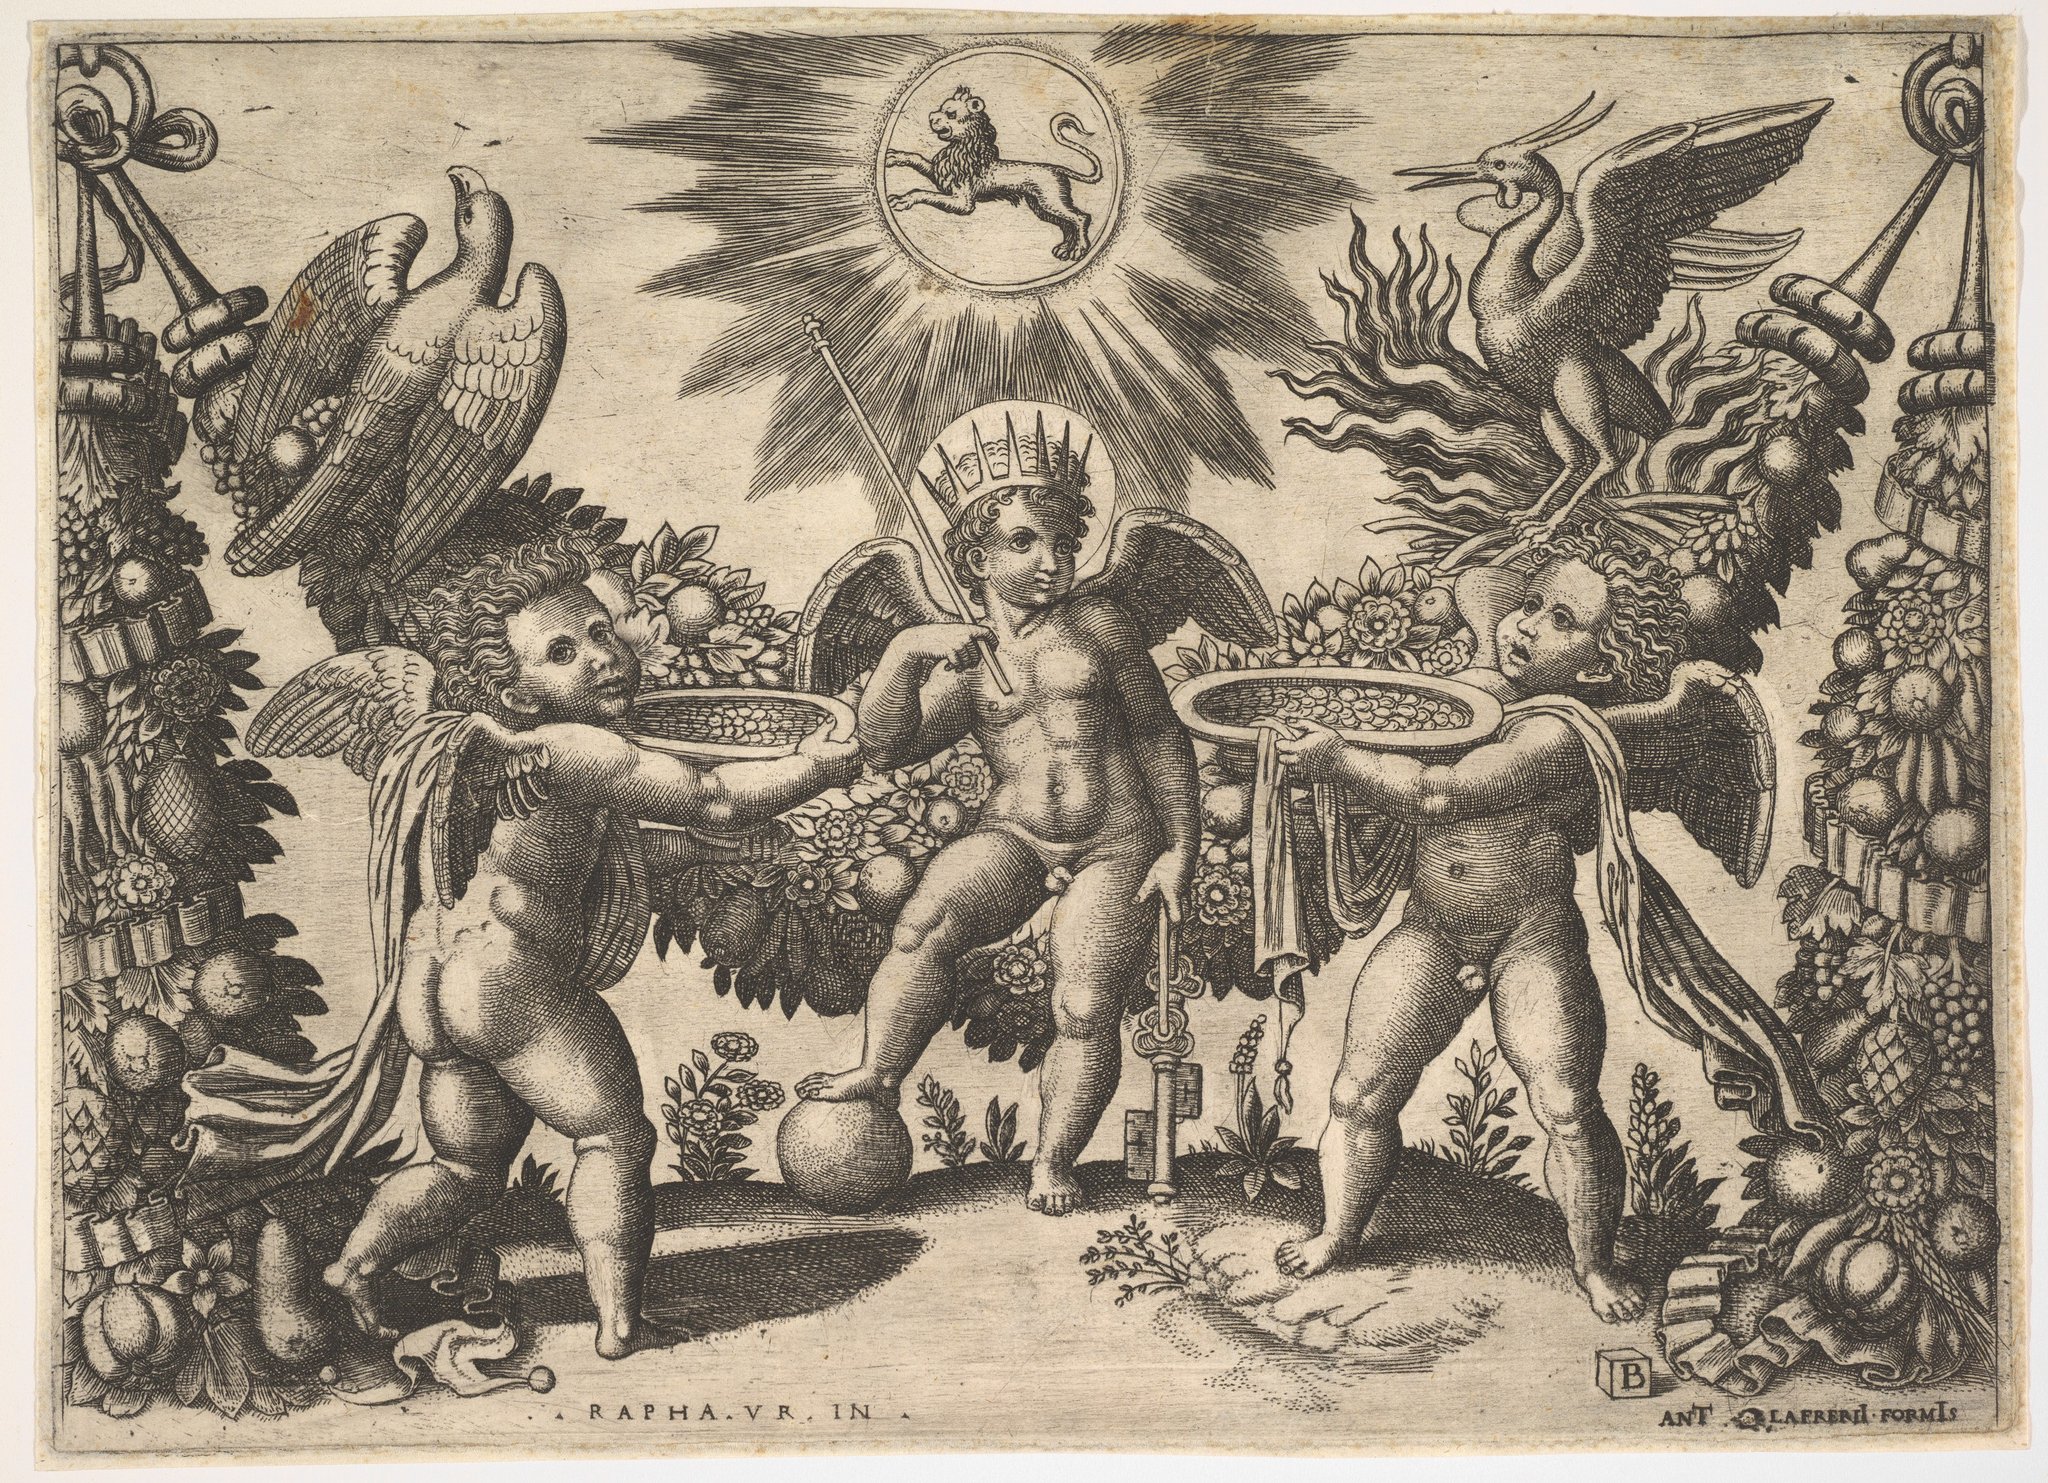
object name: print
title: Two putti presenting cups full of gold to a putto in the guise of the god of riches, from a series of tapestries made for Leo X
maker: master of the die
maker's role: artist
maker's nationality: italian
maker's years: 1525-1560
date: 1530-1540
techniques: engraving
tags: birds,lions